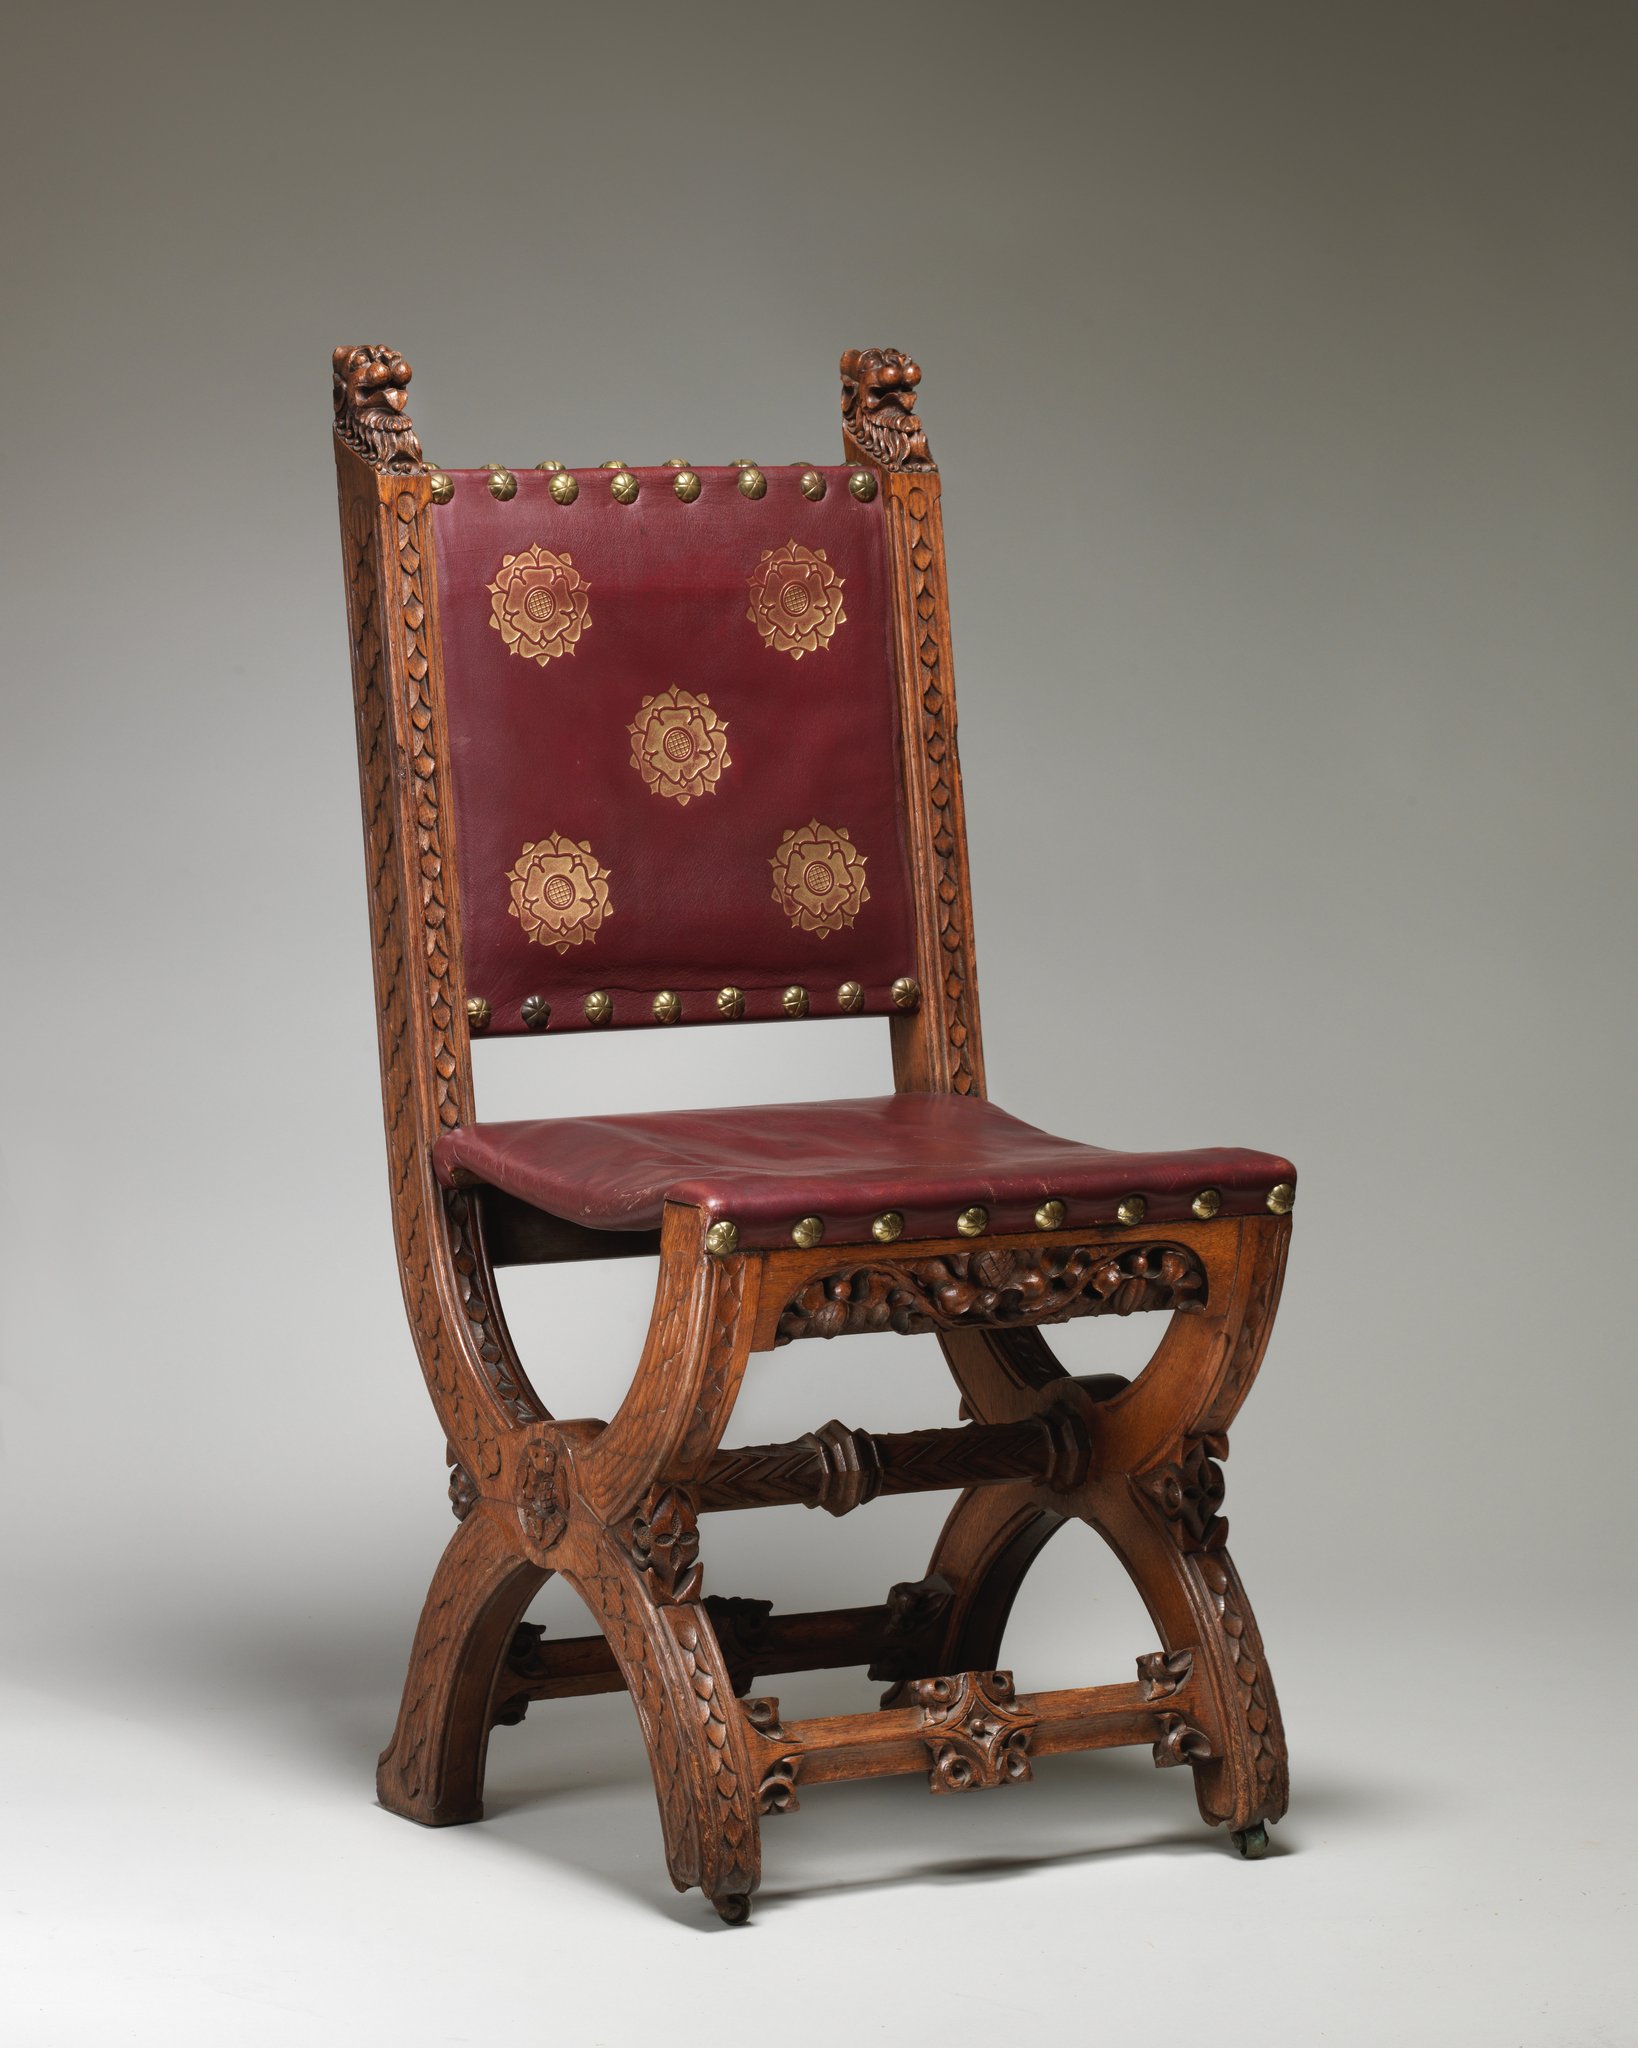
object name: chair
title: Dining room chair from the Speaker’s House, Palace of Westminster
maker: augustus welby northmore pugin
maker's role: designer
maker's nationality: british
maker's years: 1812-1852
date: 1859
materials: leather, wood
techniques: carving, gilding, stamping